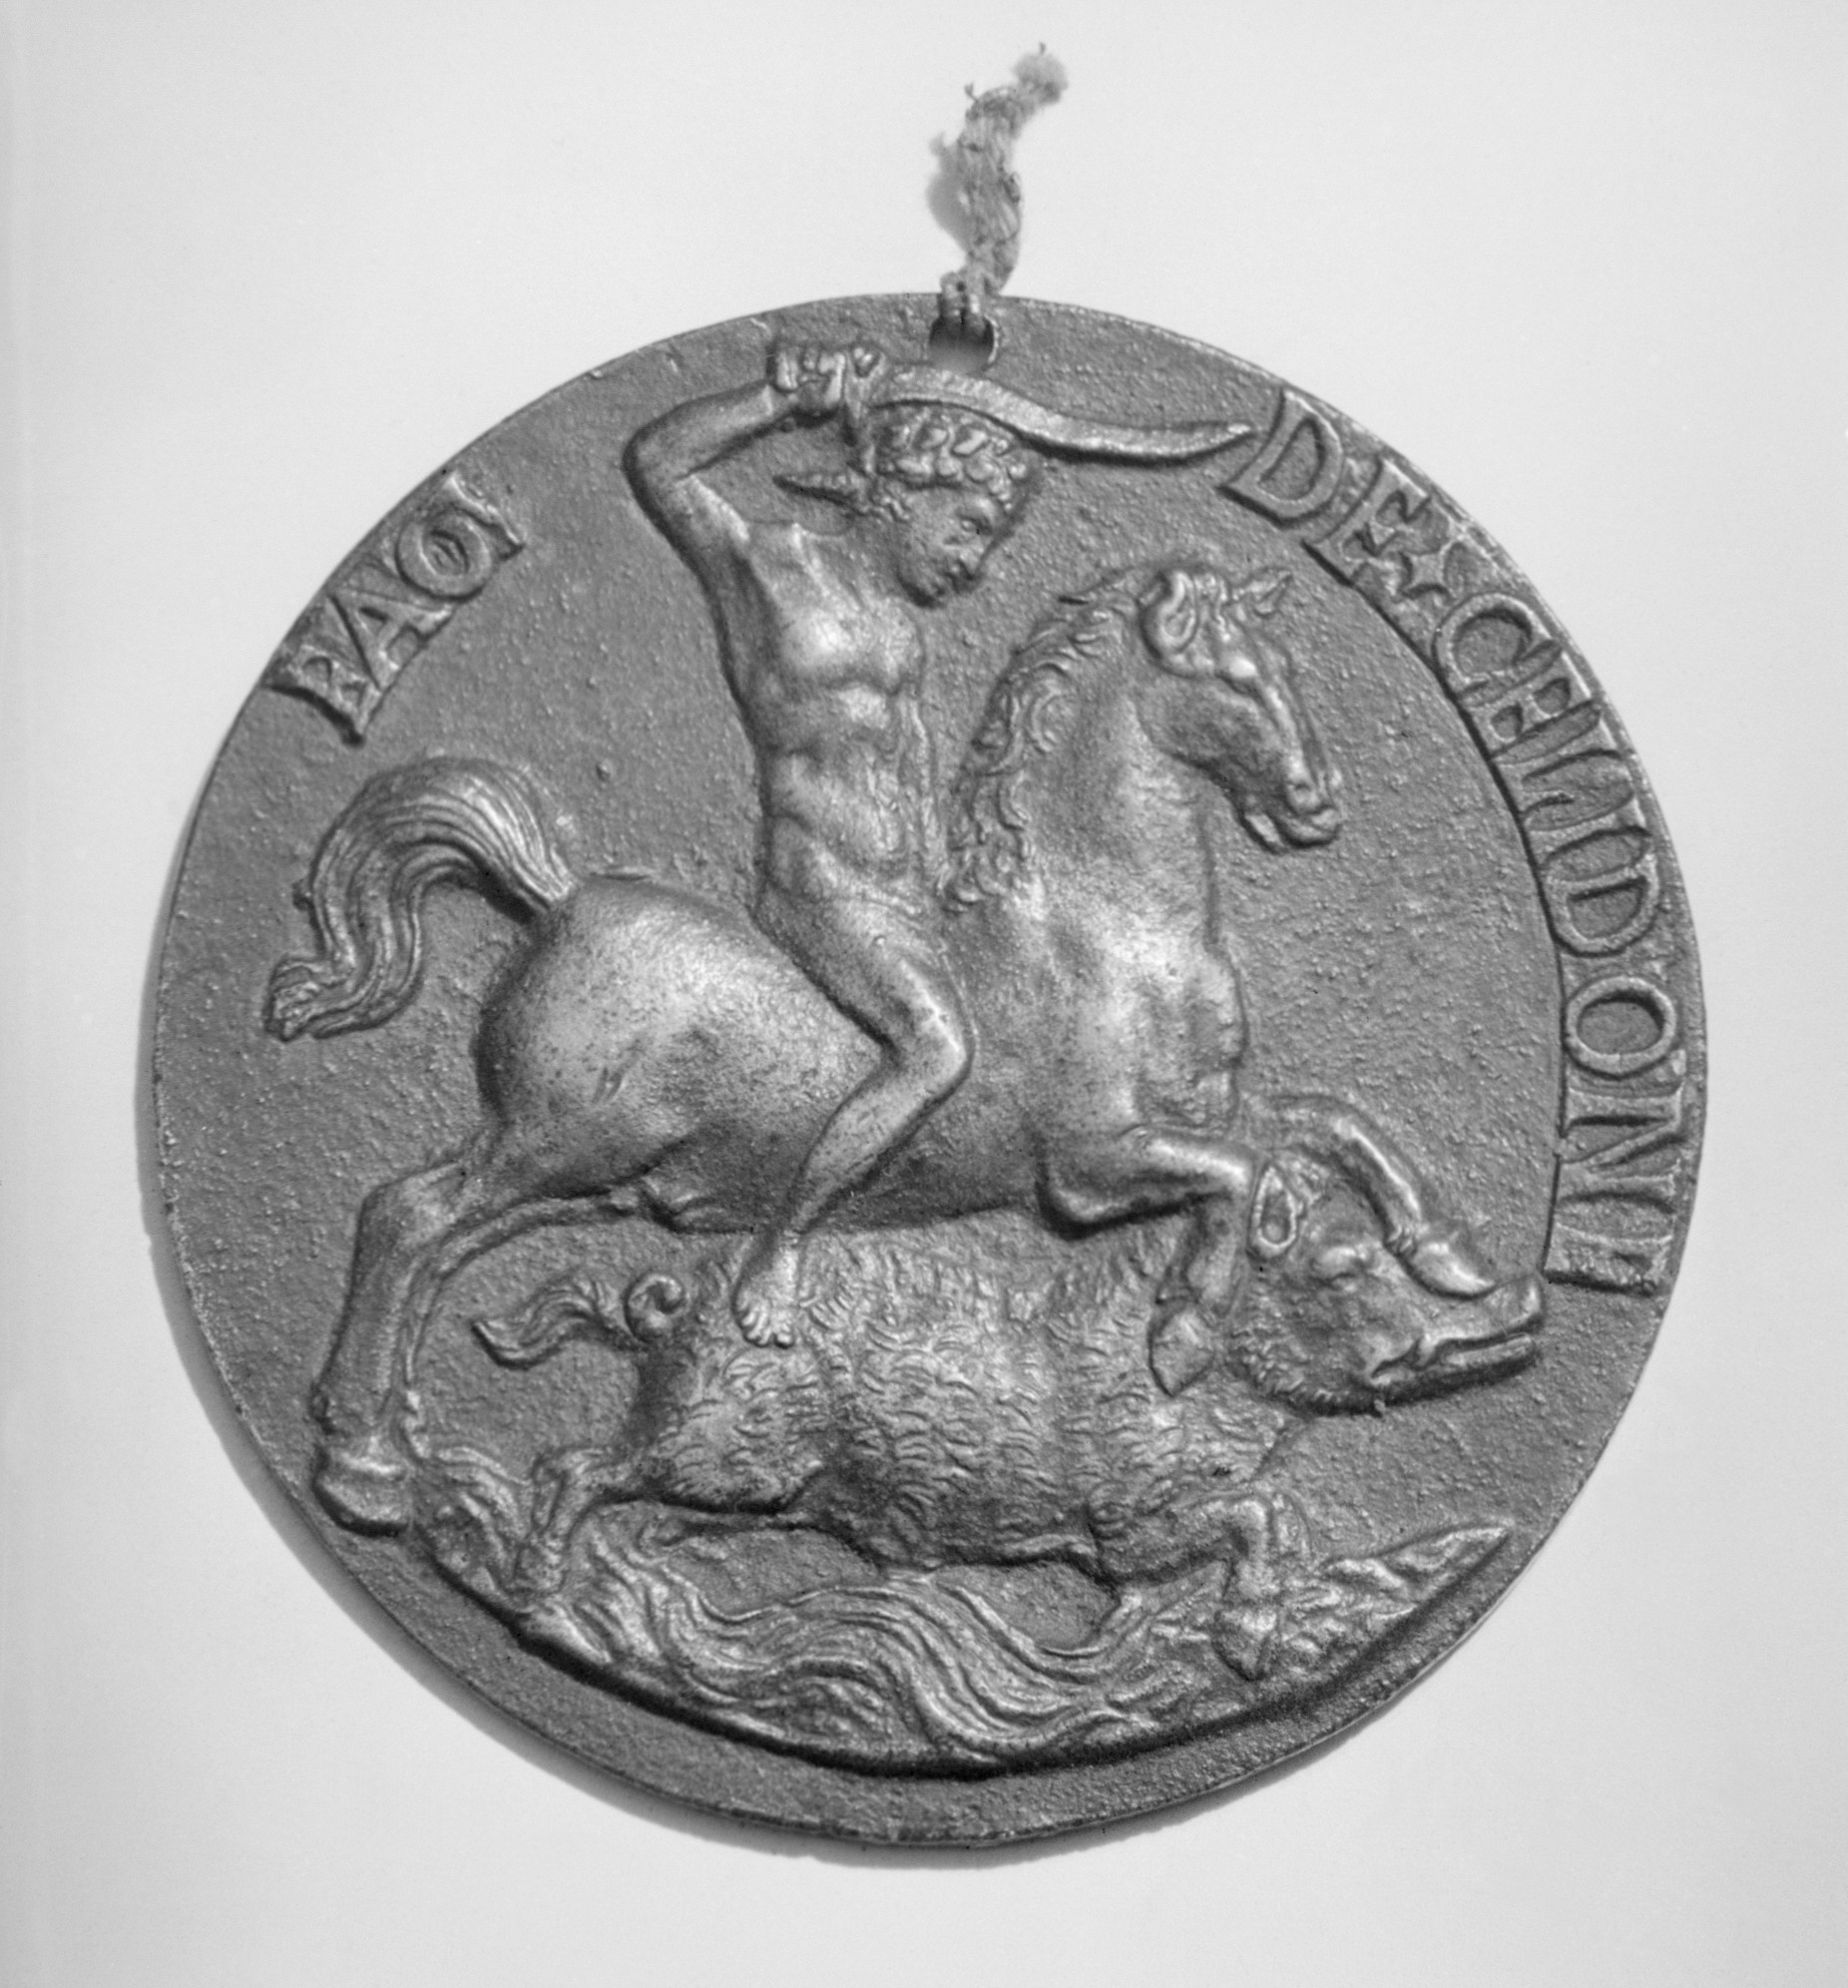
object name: plaquette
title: Meleager slaying the Calydonian boar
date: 1567-1600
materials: bronze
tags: men,boars,horses